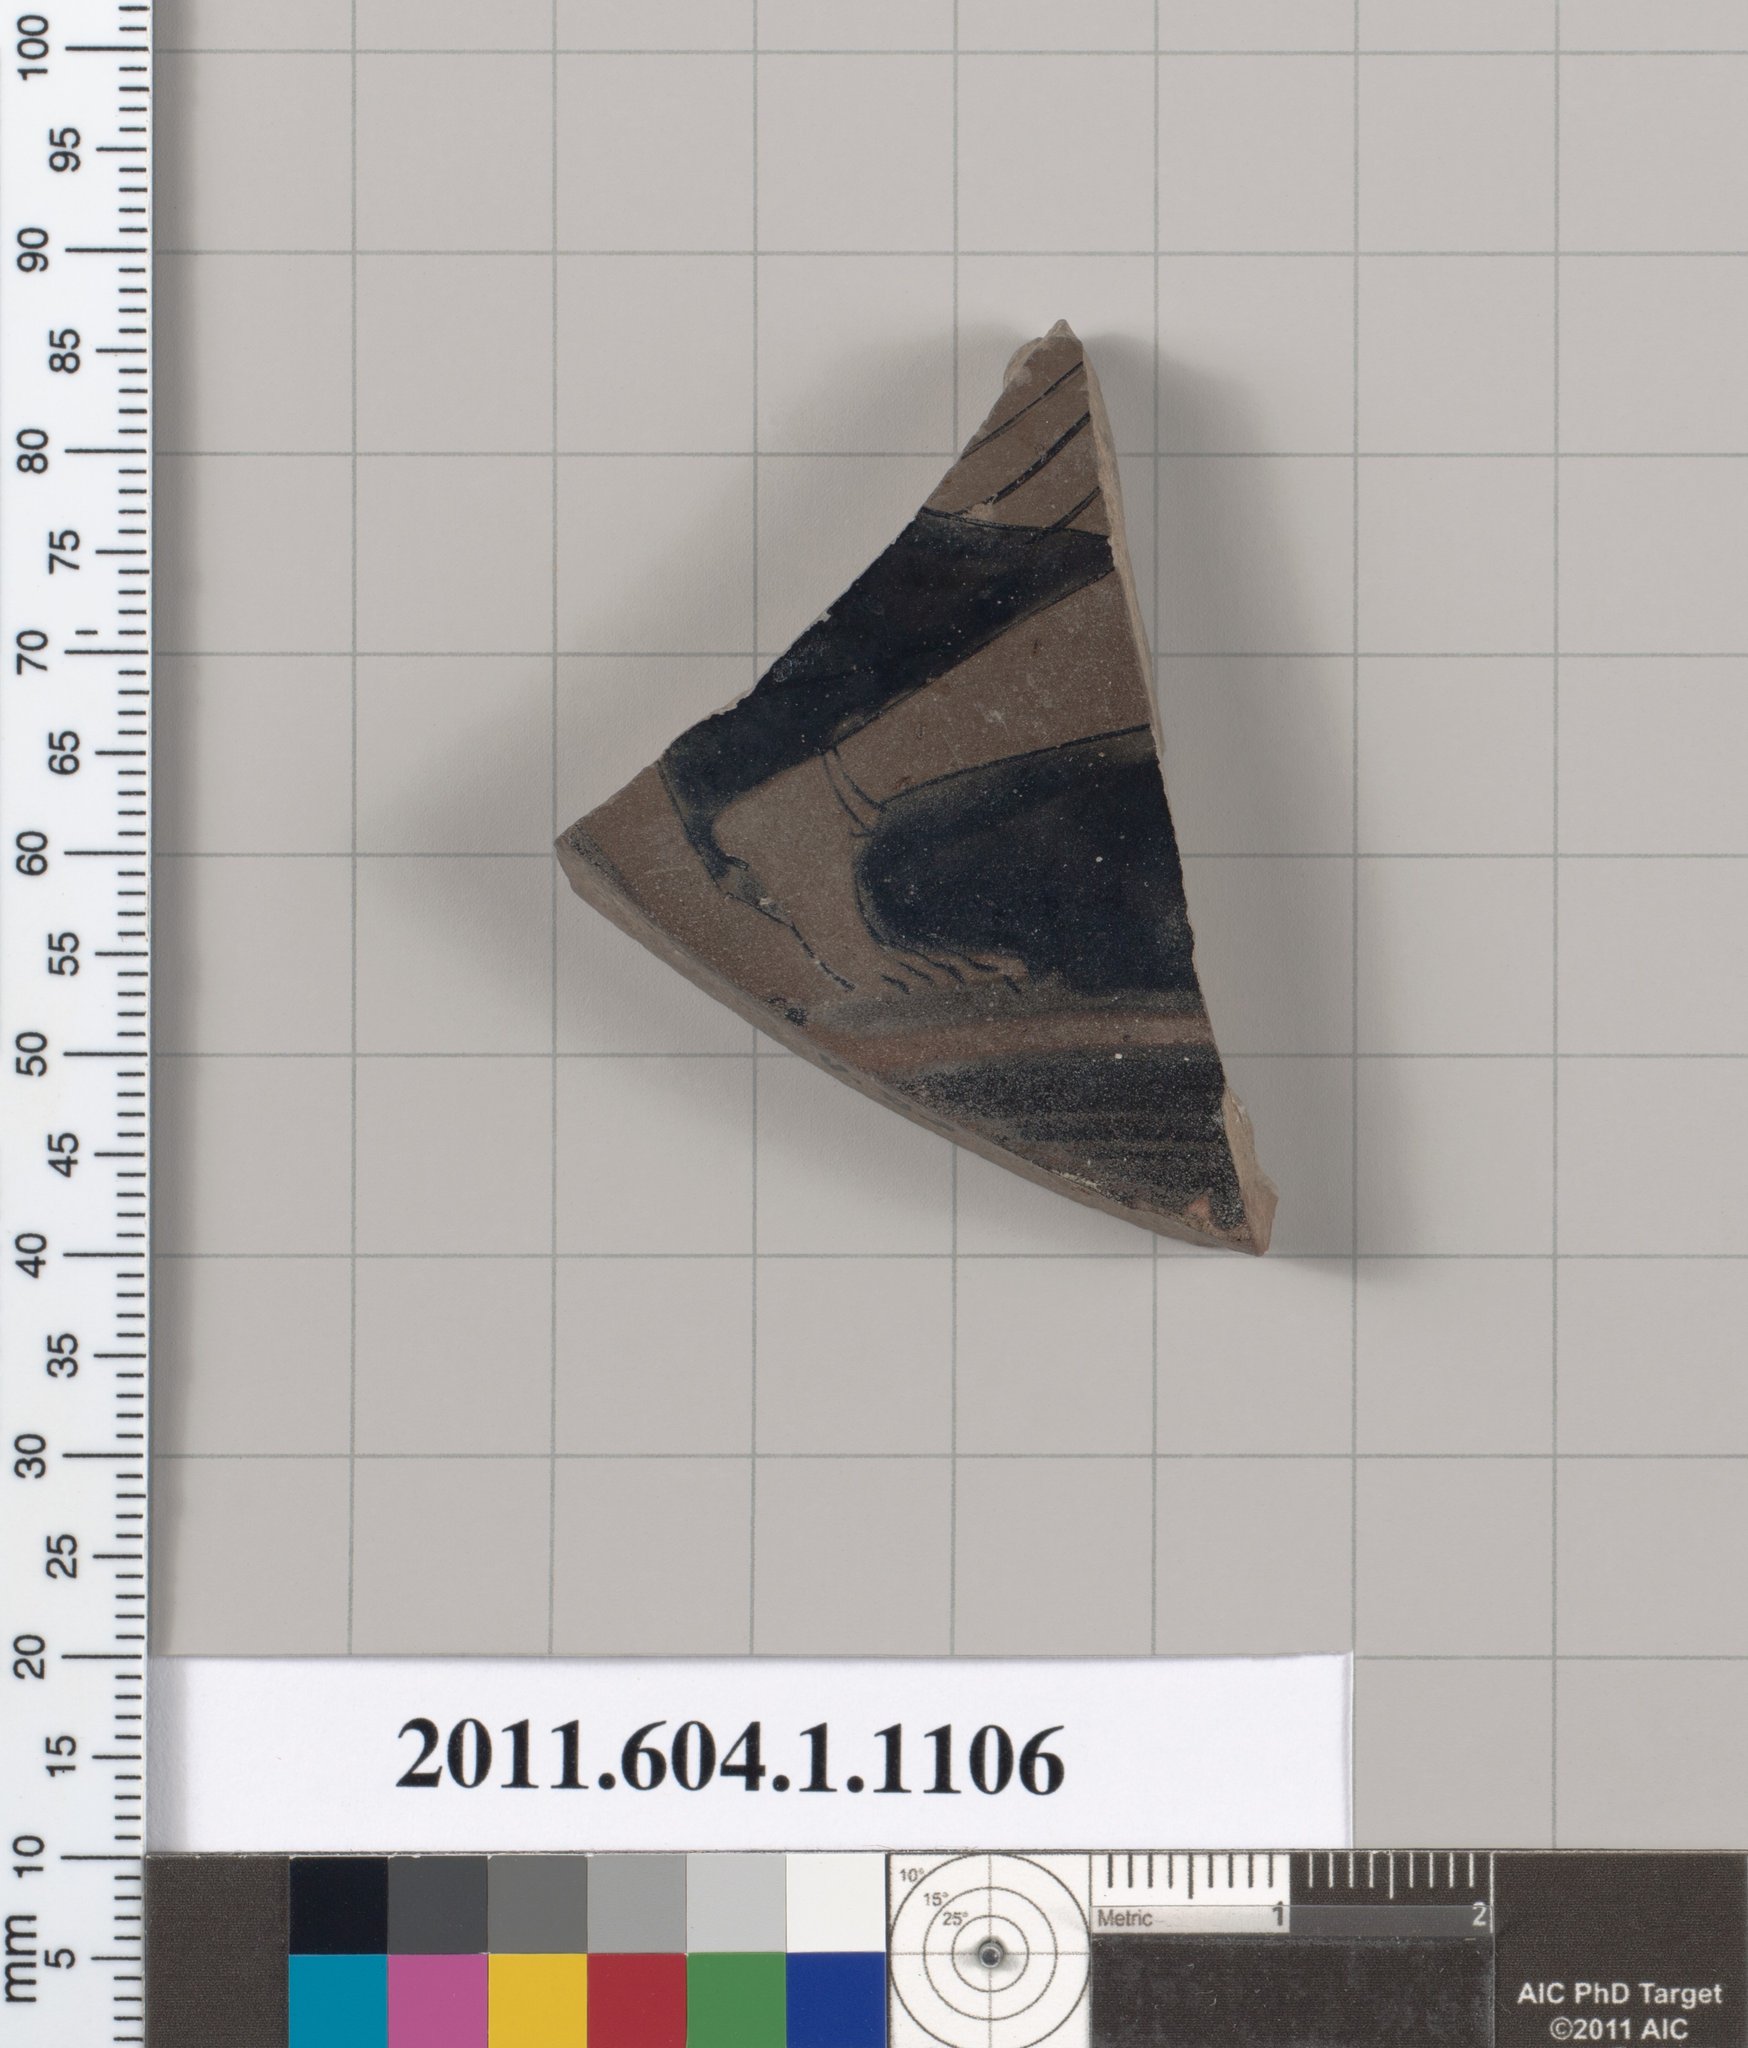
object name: kylix fragment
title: Terracotta fragment of a kylix (drinking cup)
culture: greek, attic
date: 520-500 BCE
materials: terracotta